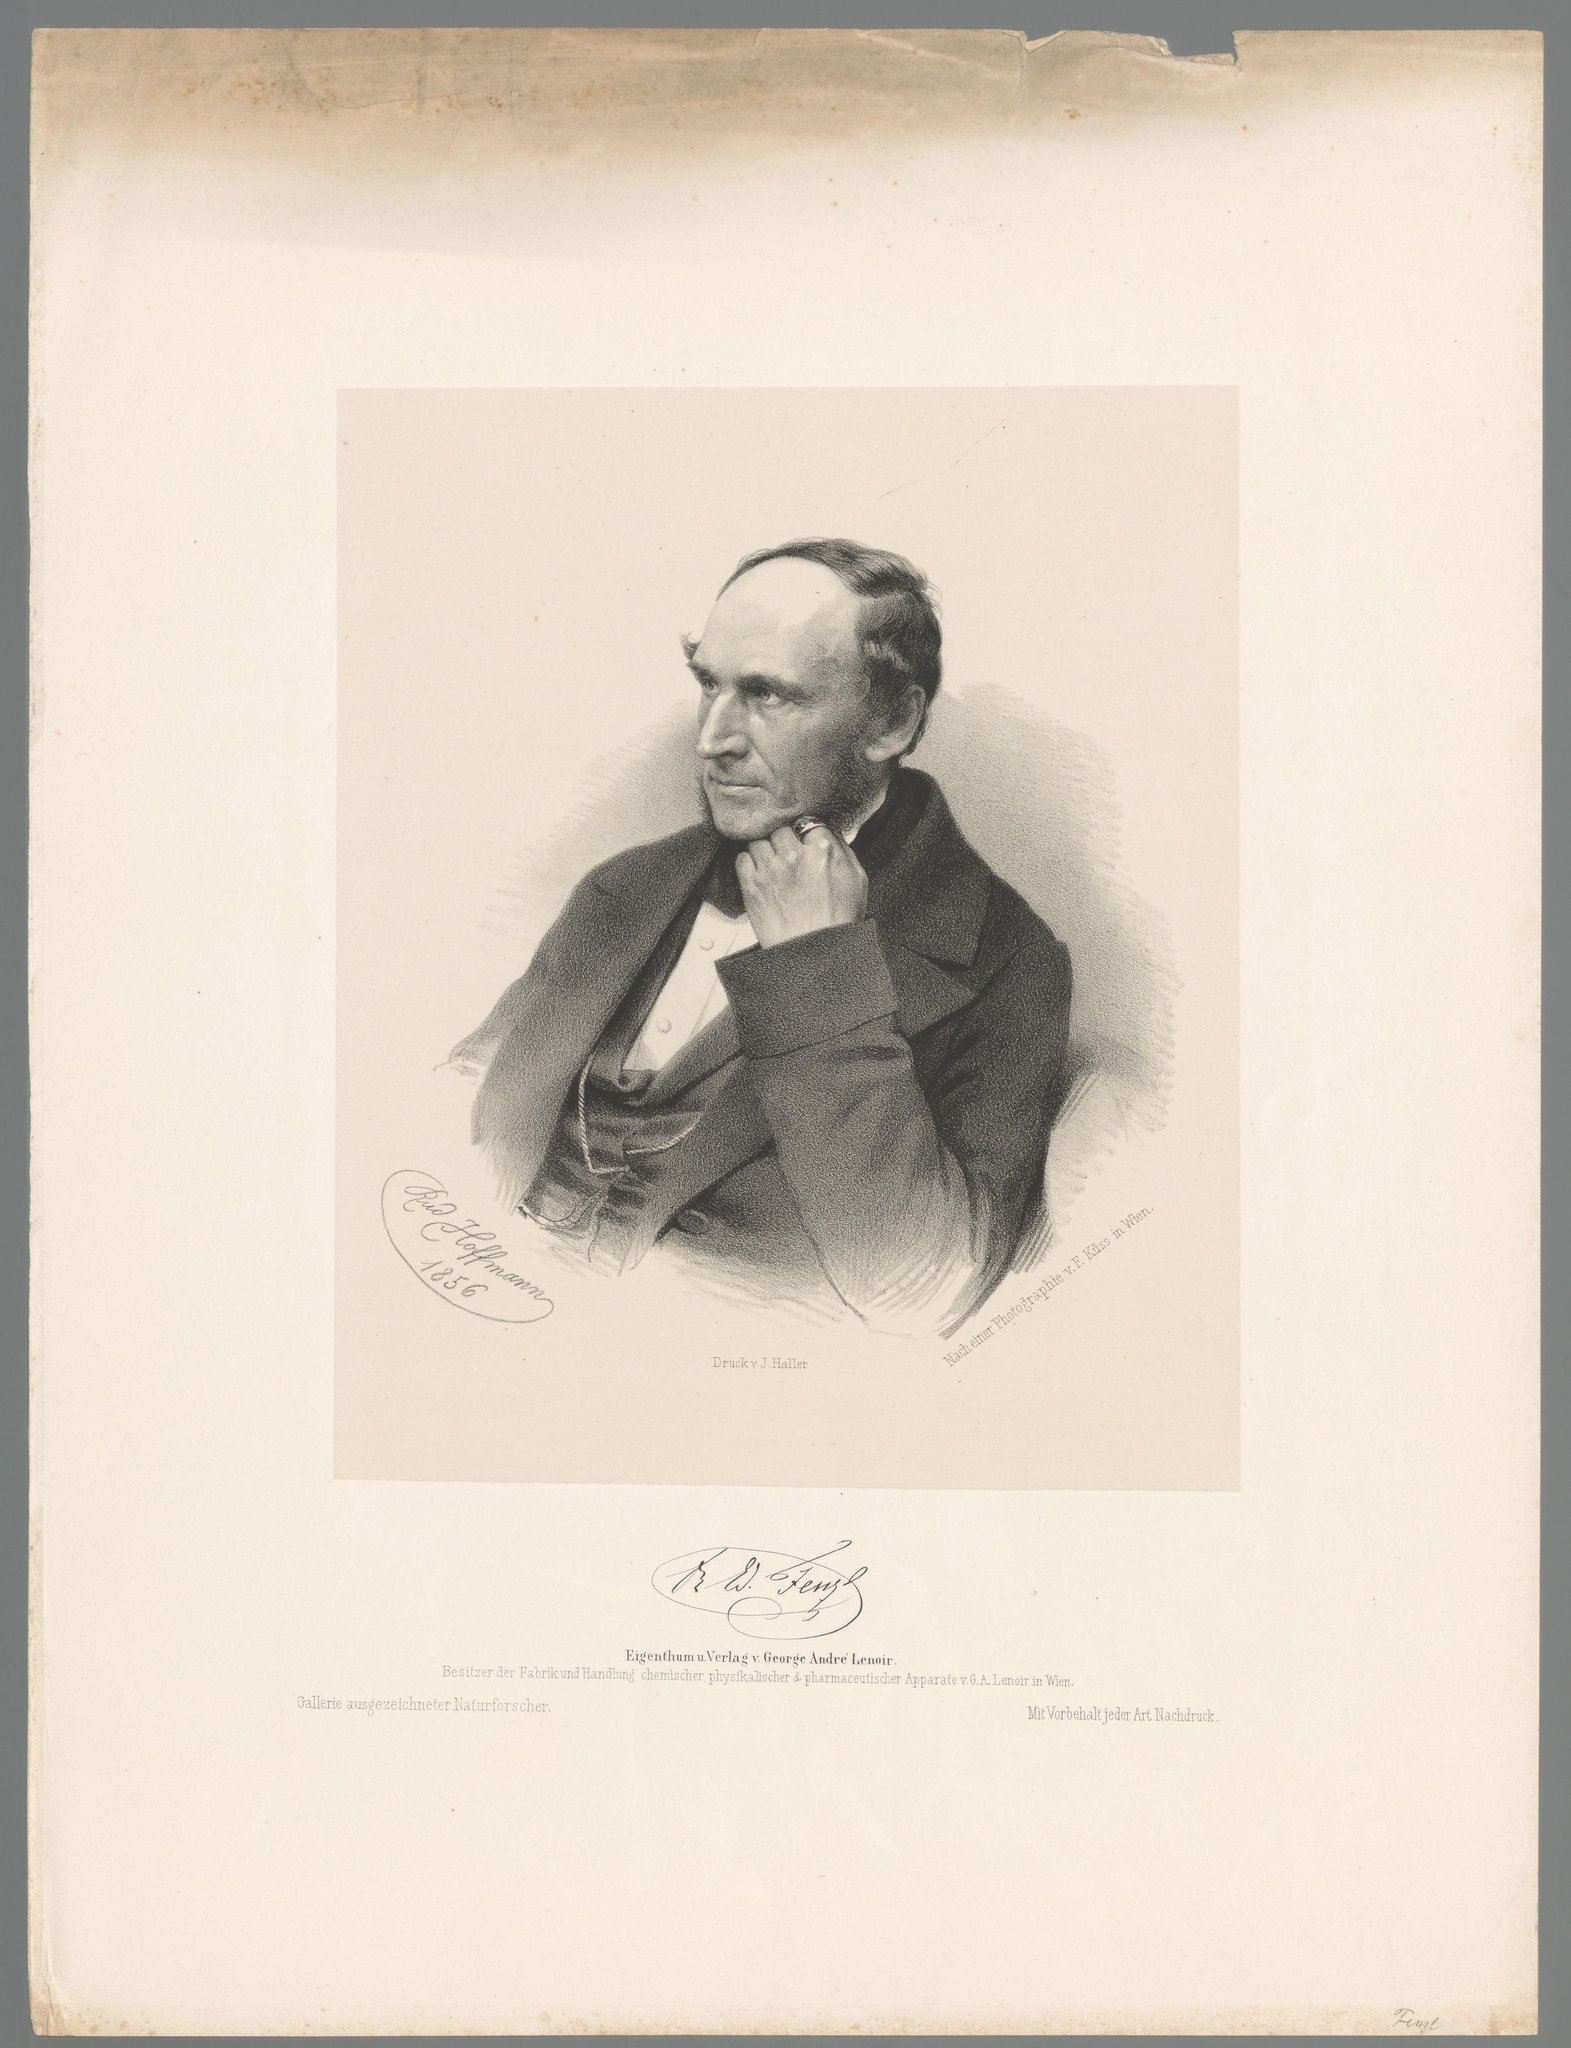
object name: print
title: Portretten van natuurwetenschappers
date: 1856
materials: paper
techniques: lithograph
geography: vienna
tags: adult man, historical persons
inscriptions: collector's mark: Lugt 2228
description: Deze prent behoort tot een serie met 100 portretten van natuurwetenschappers, uitgegeven tussen 1856-1860.